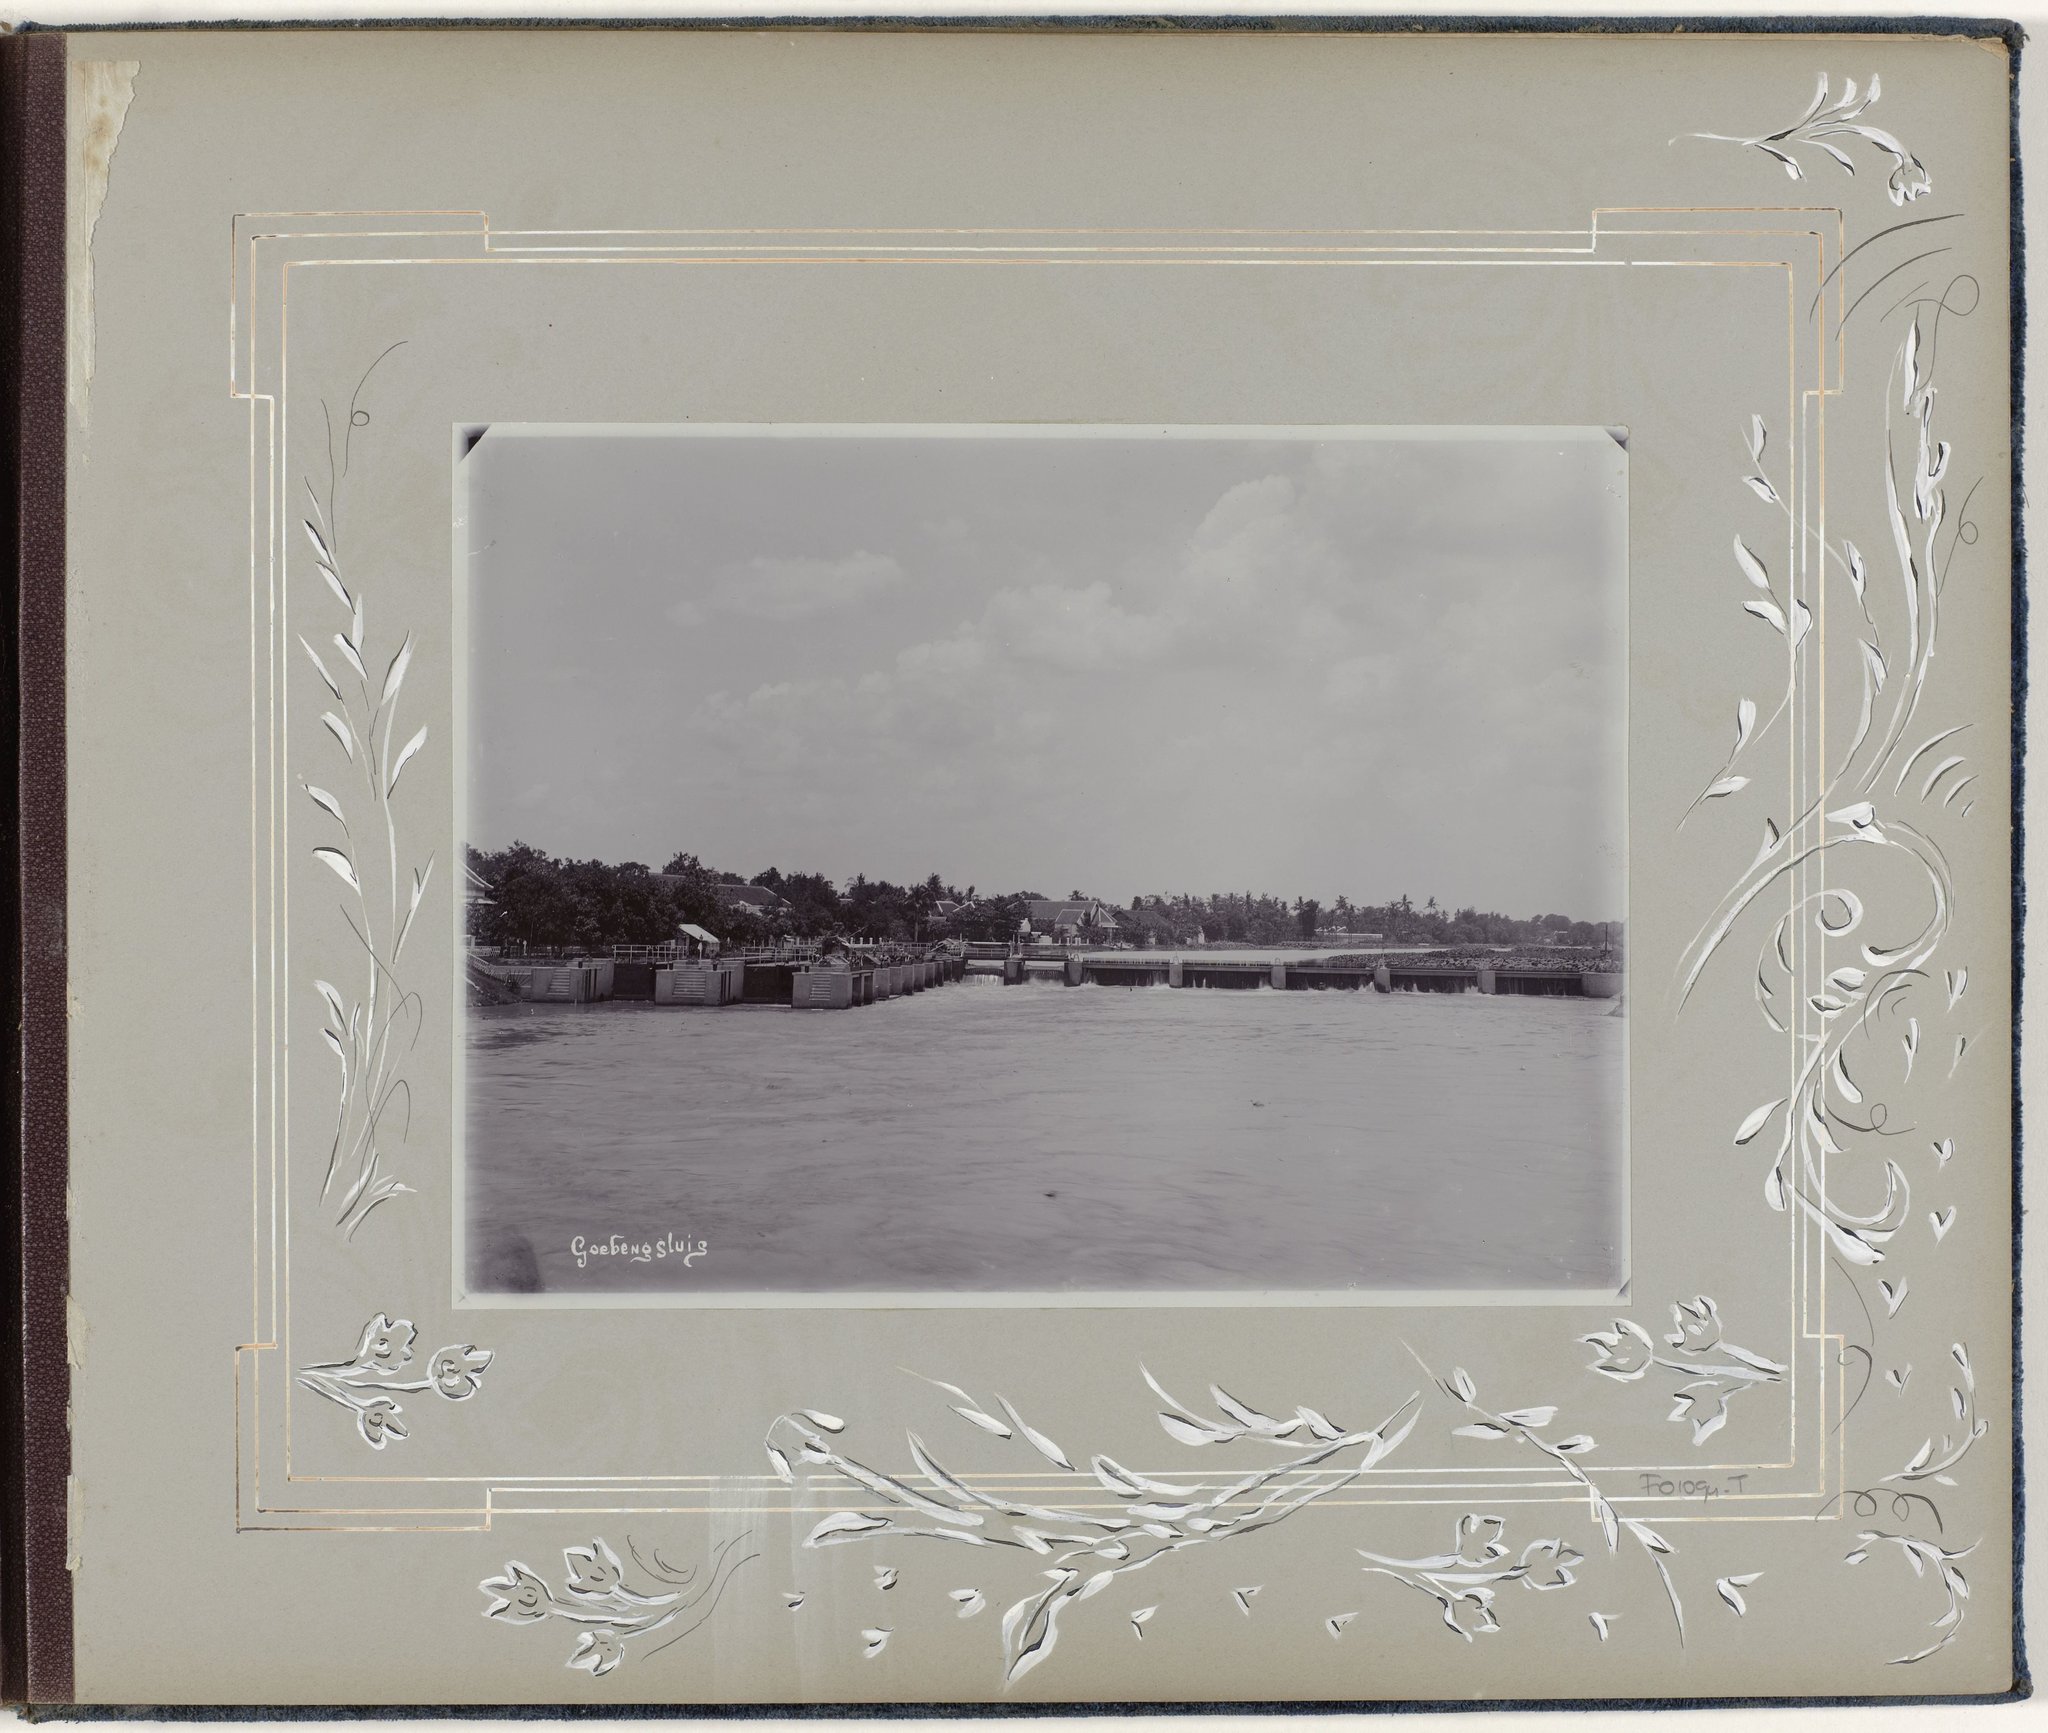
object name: photograph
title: Gezicht op de Goebengsluis bij Soerabaja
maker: Anonymous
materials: cardboard, paper, photographic support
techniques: gelatin silver print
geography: surabaya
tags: sluice, weir (+ landscape with figures, staffage), surabaya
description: Onderdeel van Herinneringsalbum met foto's van Soerabaja.